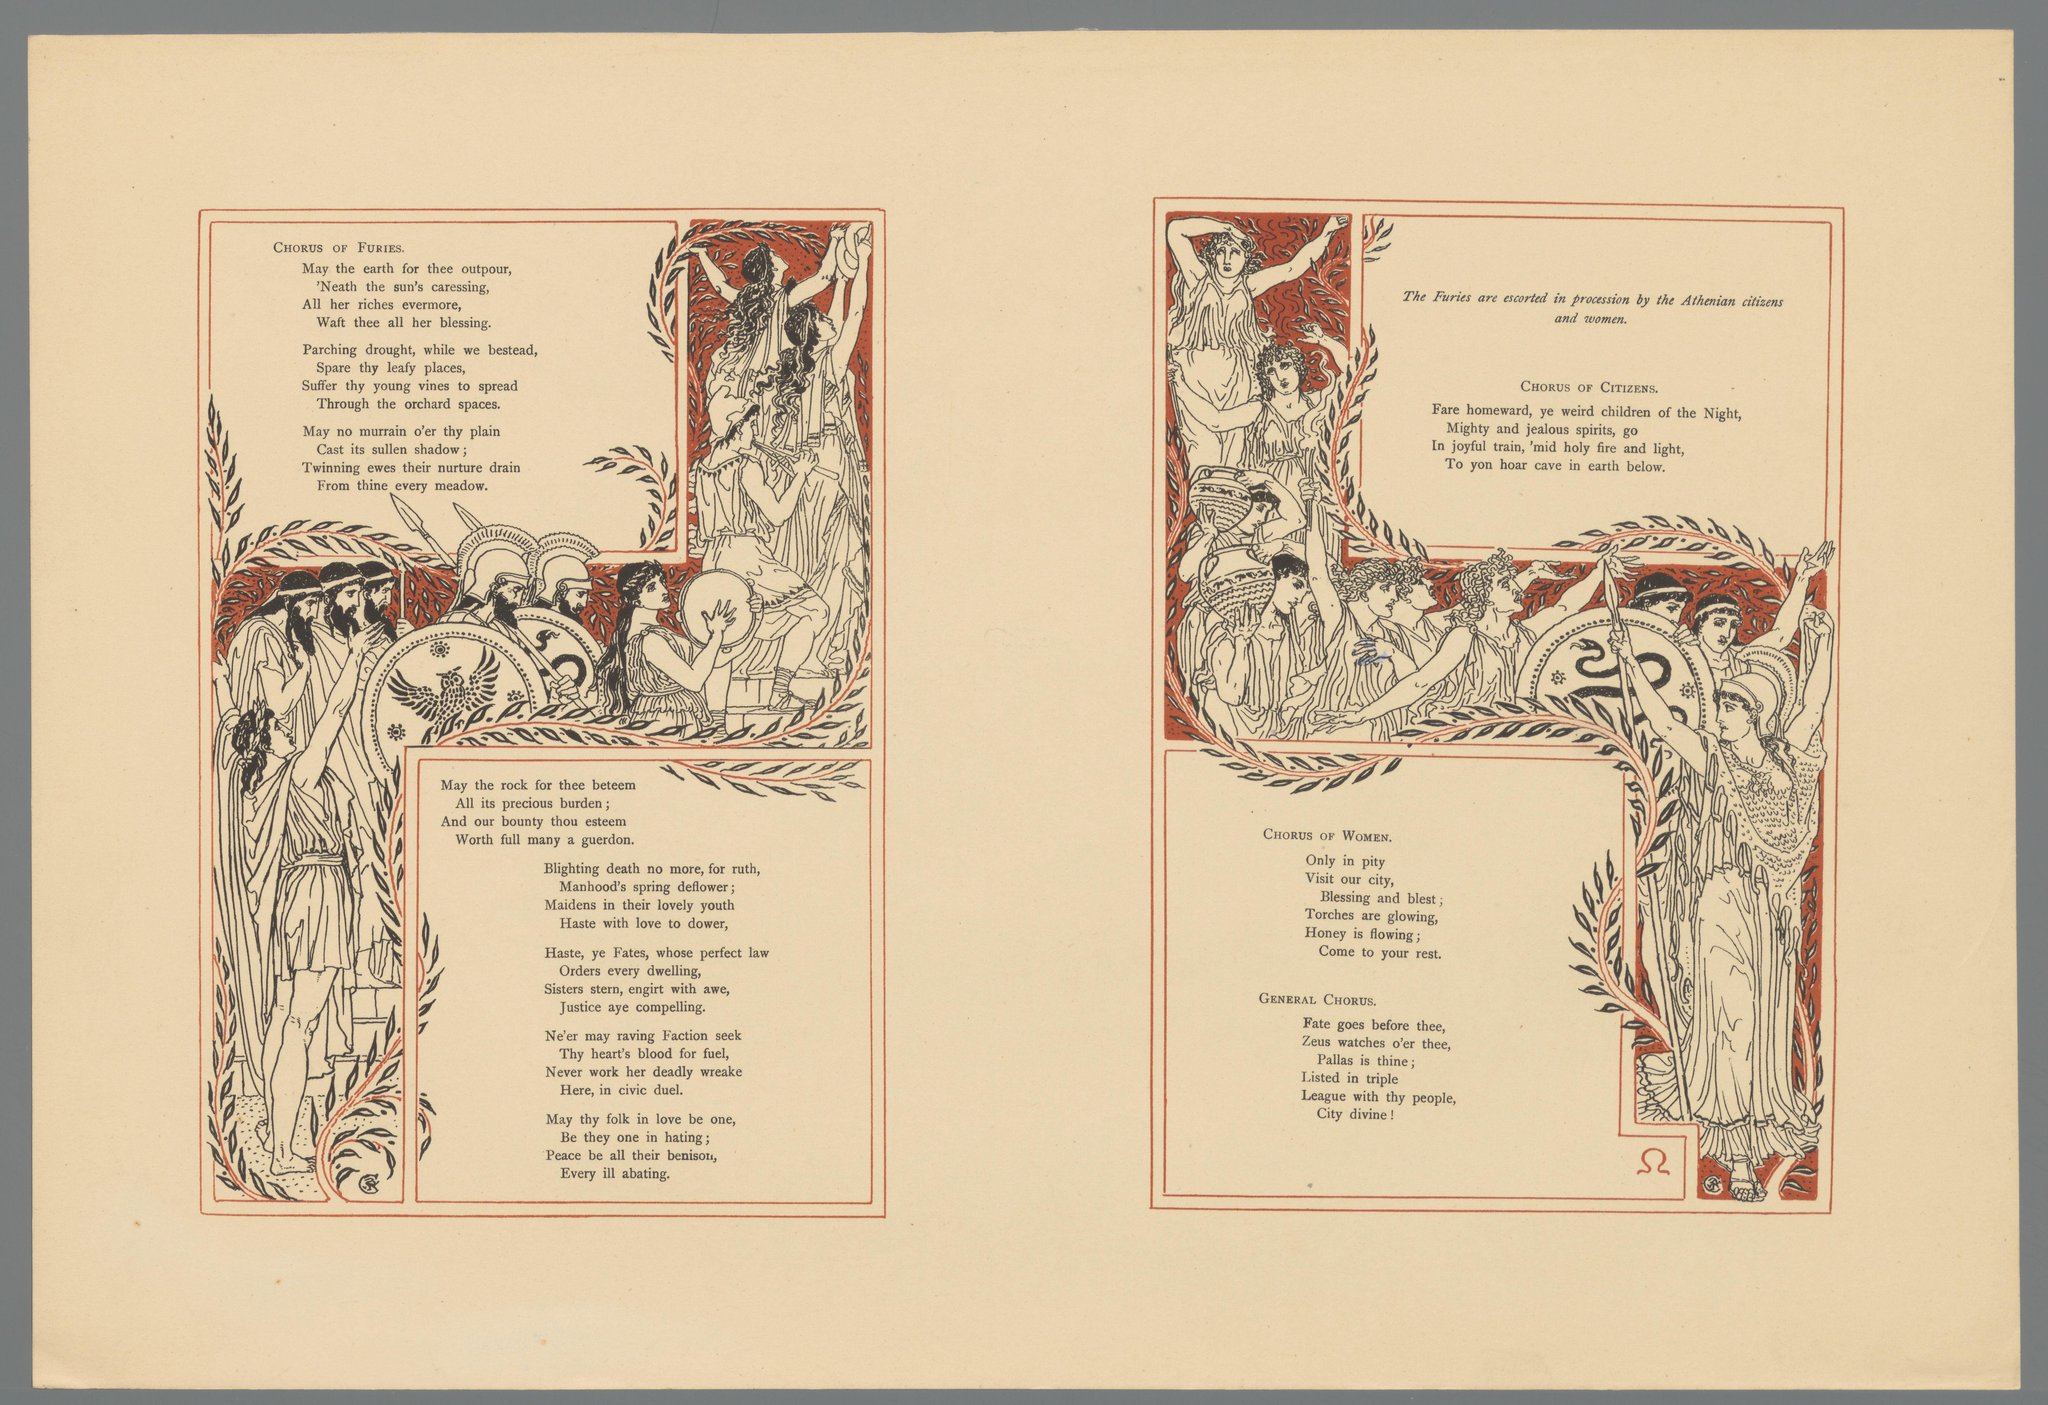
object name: book illustration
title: Processie met furiën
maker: walter crane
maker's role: draughtsman, print maker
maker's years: 1845-1915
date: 1887-1888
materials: paper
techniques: letterpress printing, lithograph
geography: london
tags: furies, dirae (erinyes), eumenides; 'furie' (ripa), procession ~ non-christian religions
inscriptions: collector's mark: Lugt 2228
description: Prent uit: Warr, George C. Echoes of Hellas: the tale of Troy & the story of Orestes from Homer & Aeschylus. Londen: Marcus Ward & Company, [1887/1888].